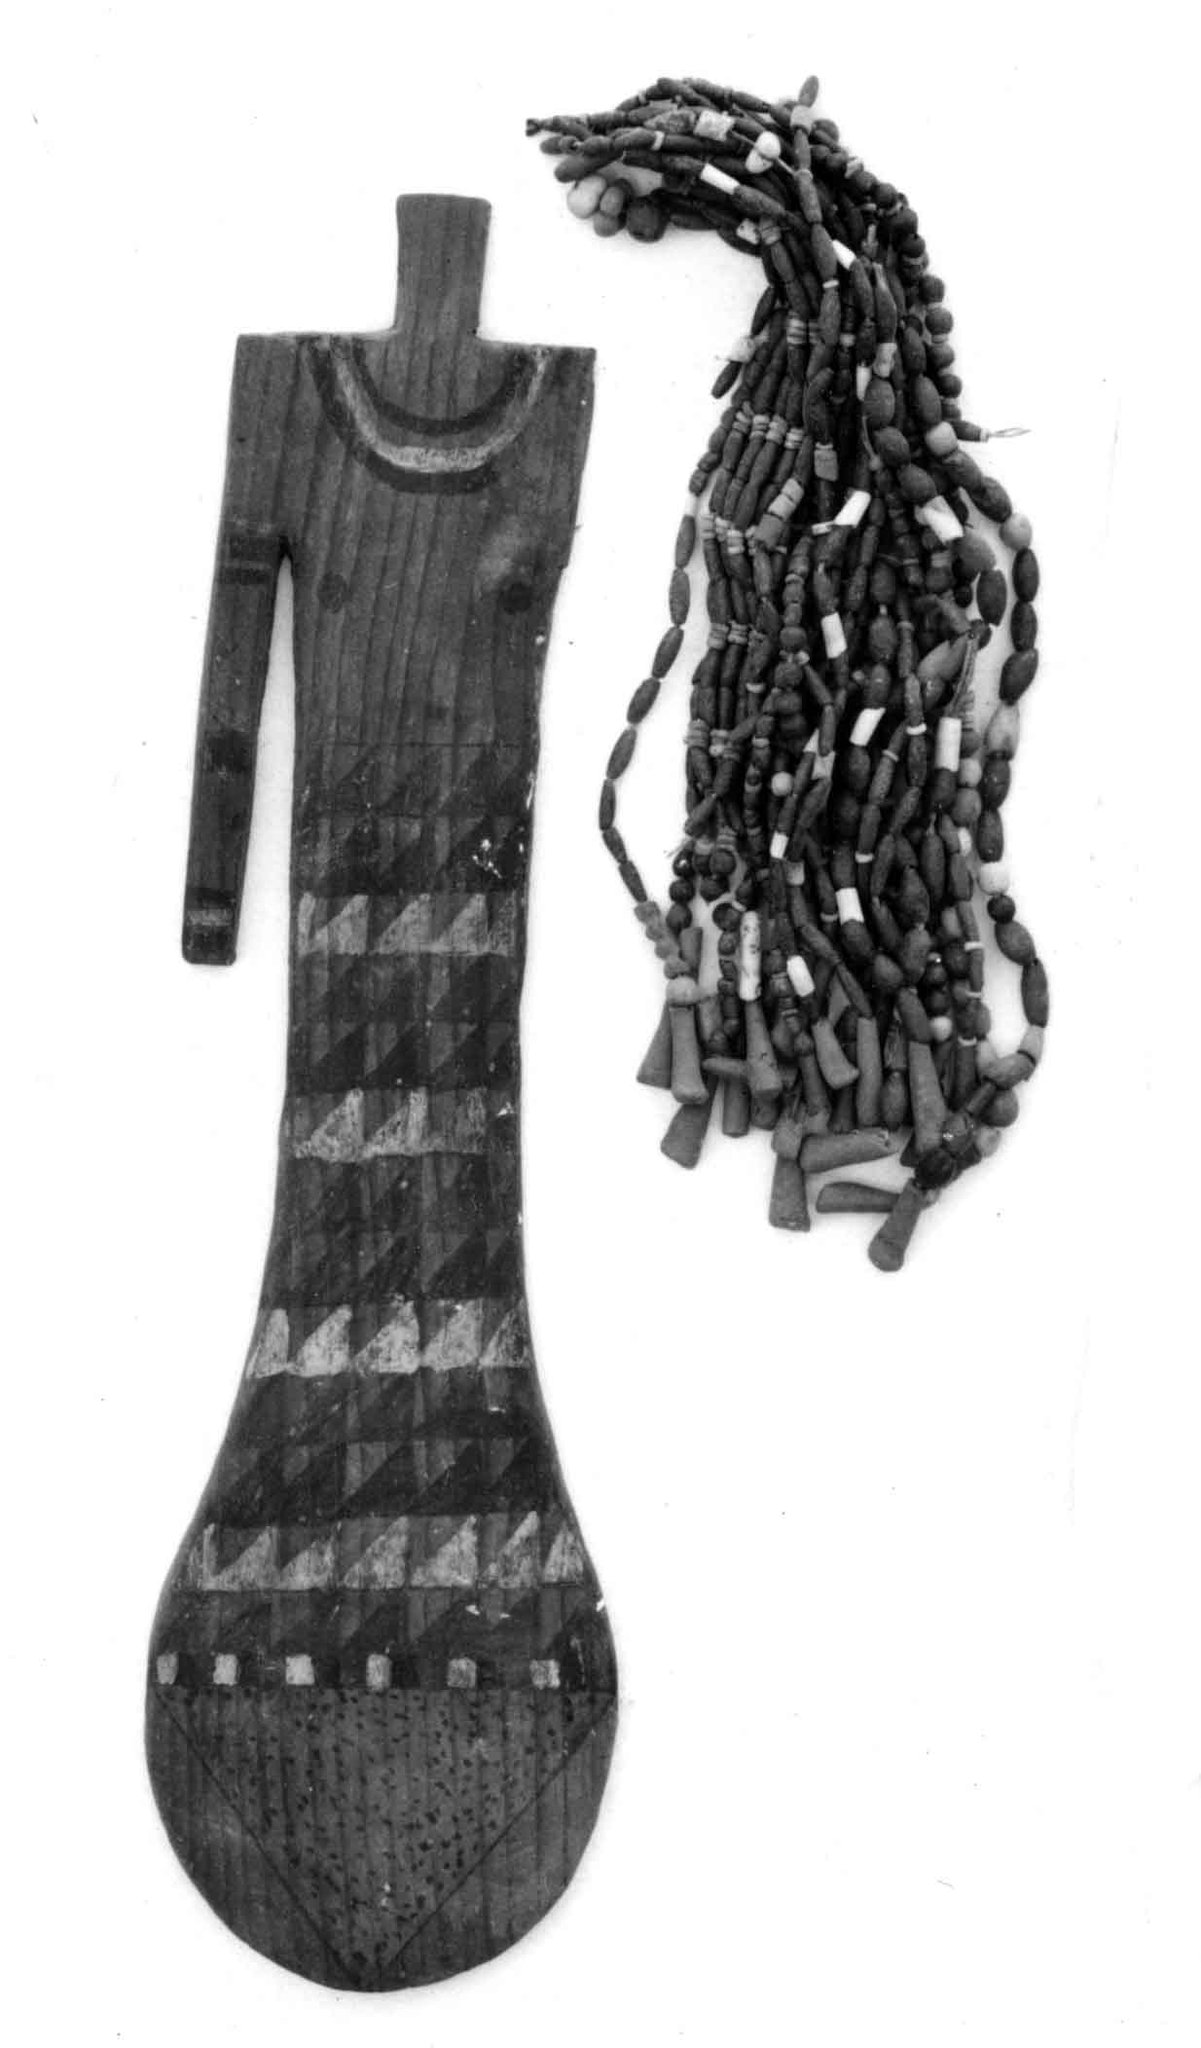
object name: paddle doll, bead hair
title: Paddle Doll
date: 2000-1988 BCE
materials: faience, linen, mud, wood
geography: egypt